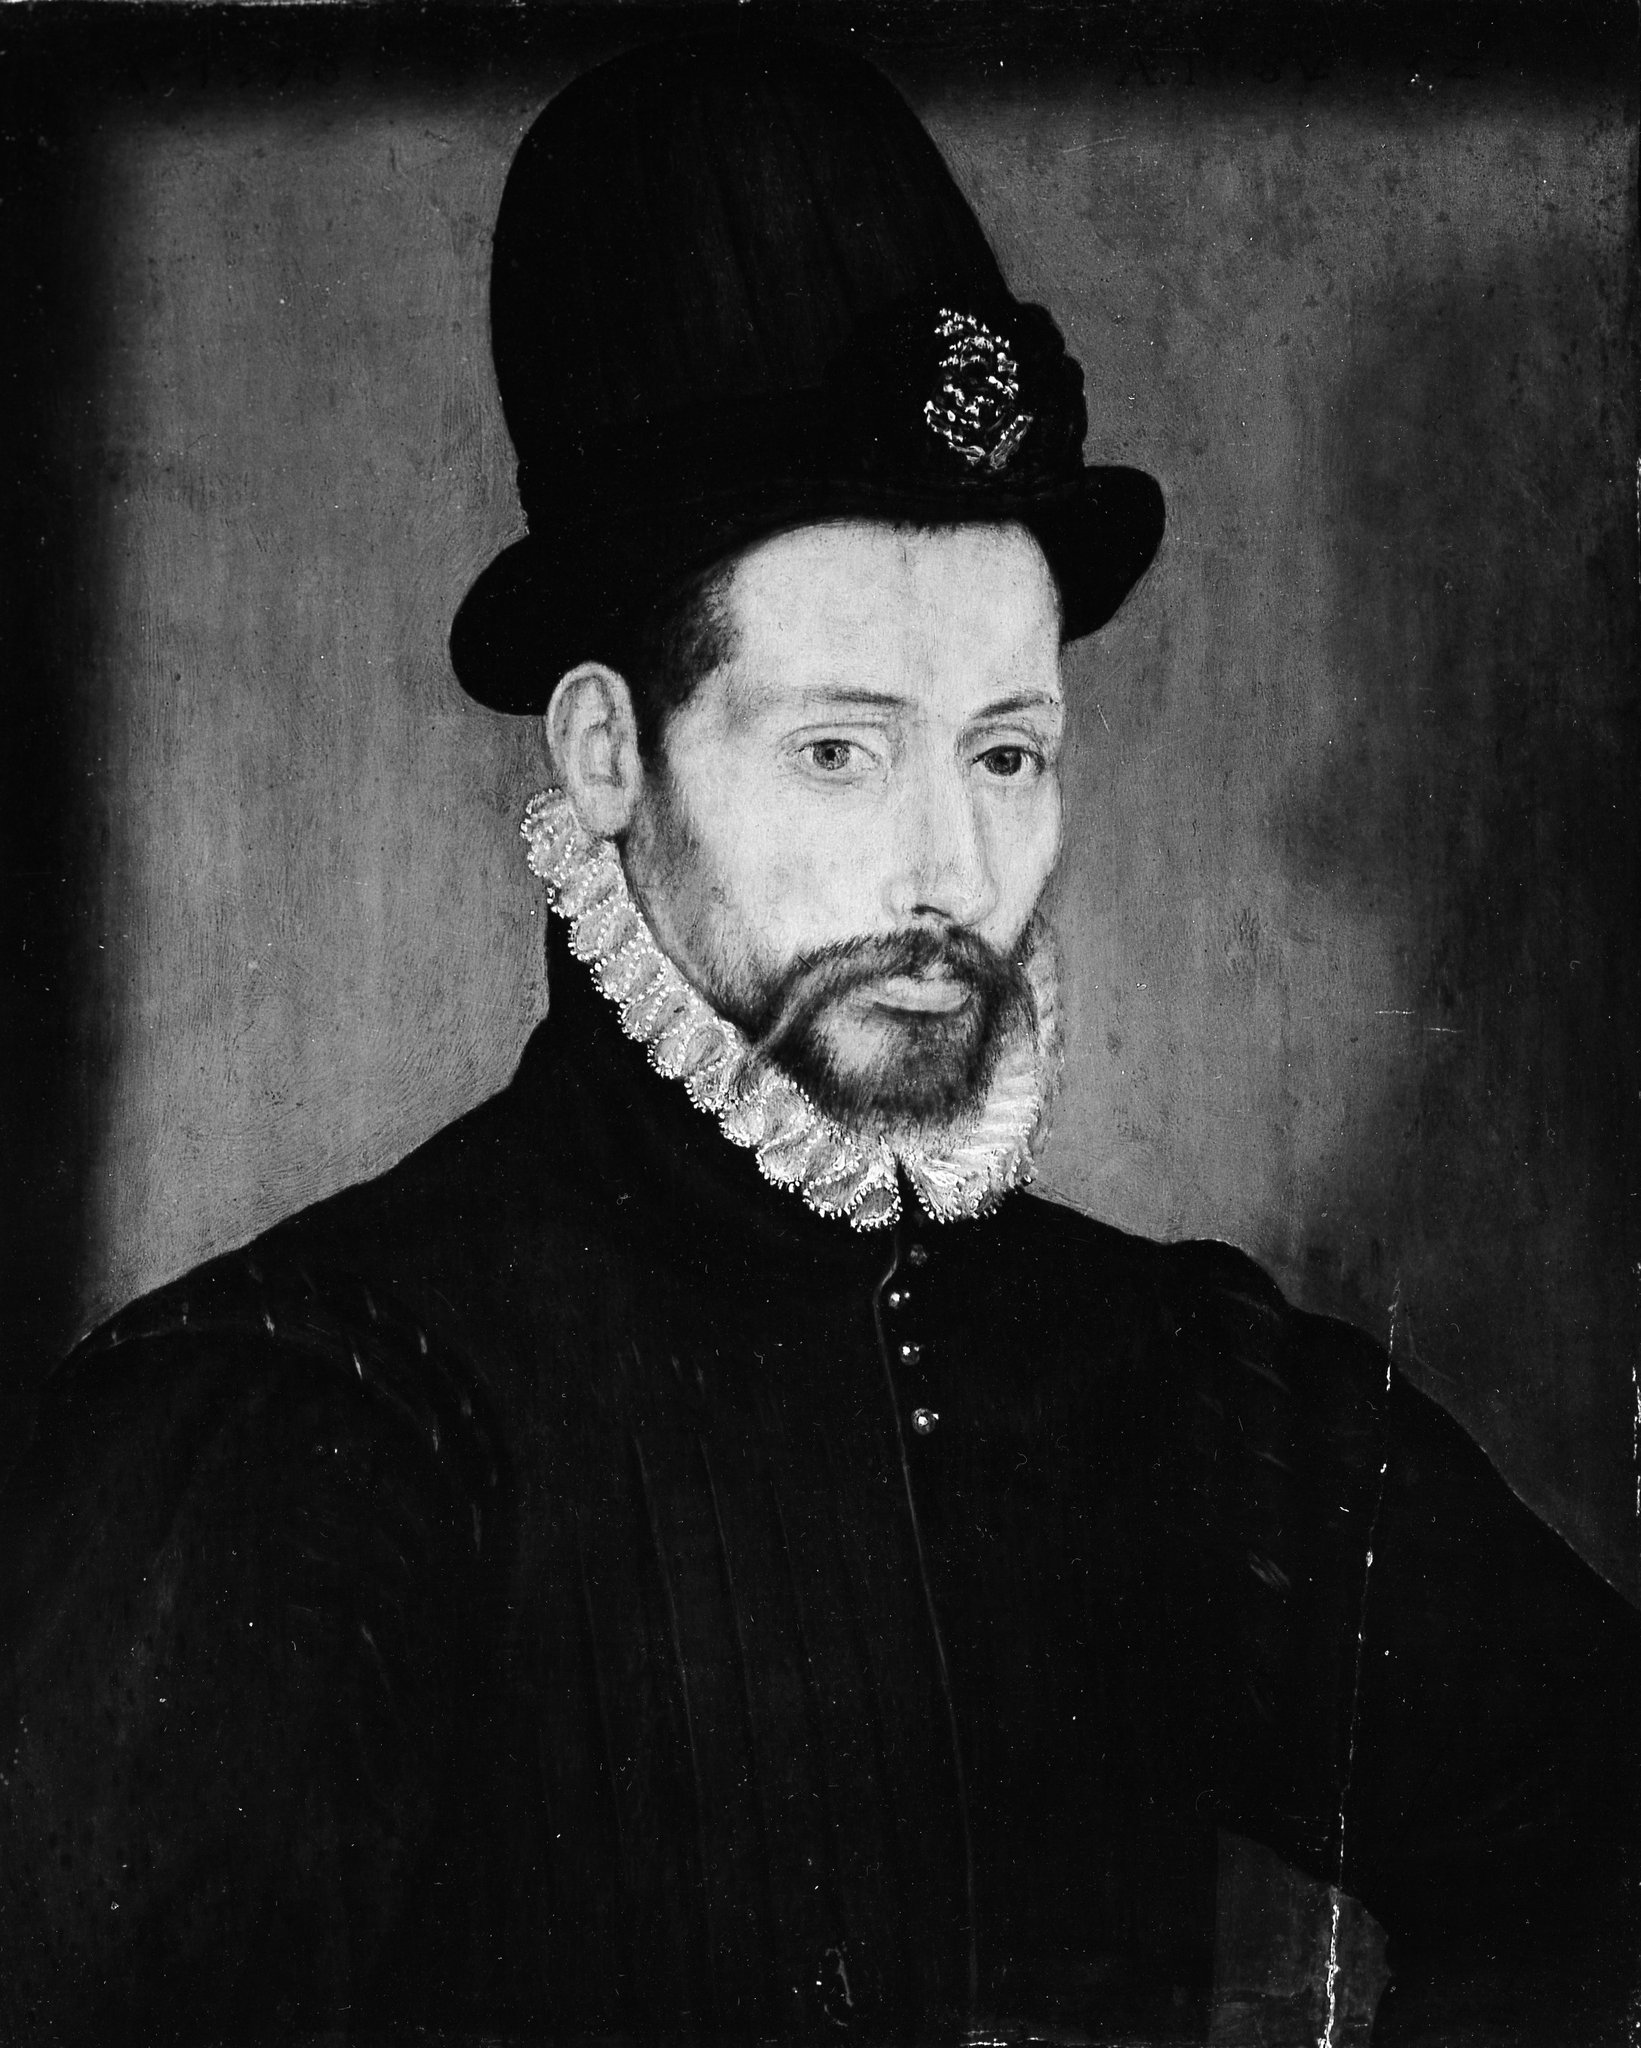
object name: painting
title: Portrait of a Man with a High Hat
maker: french painter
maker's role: artist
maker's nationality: french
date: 1570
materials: oil, wood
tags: men,portraits